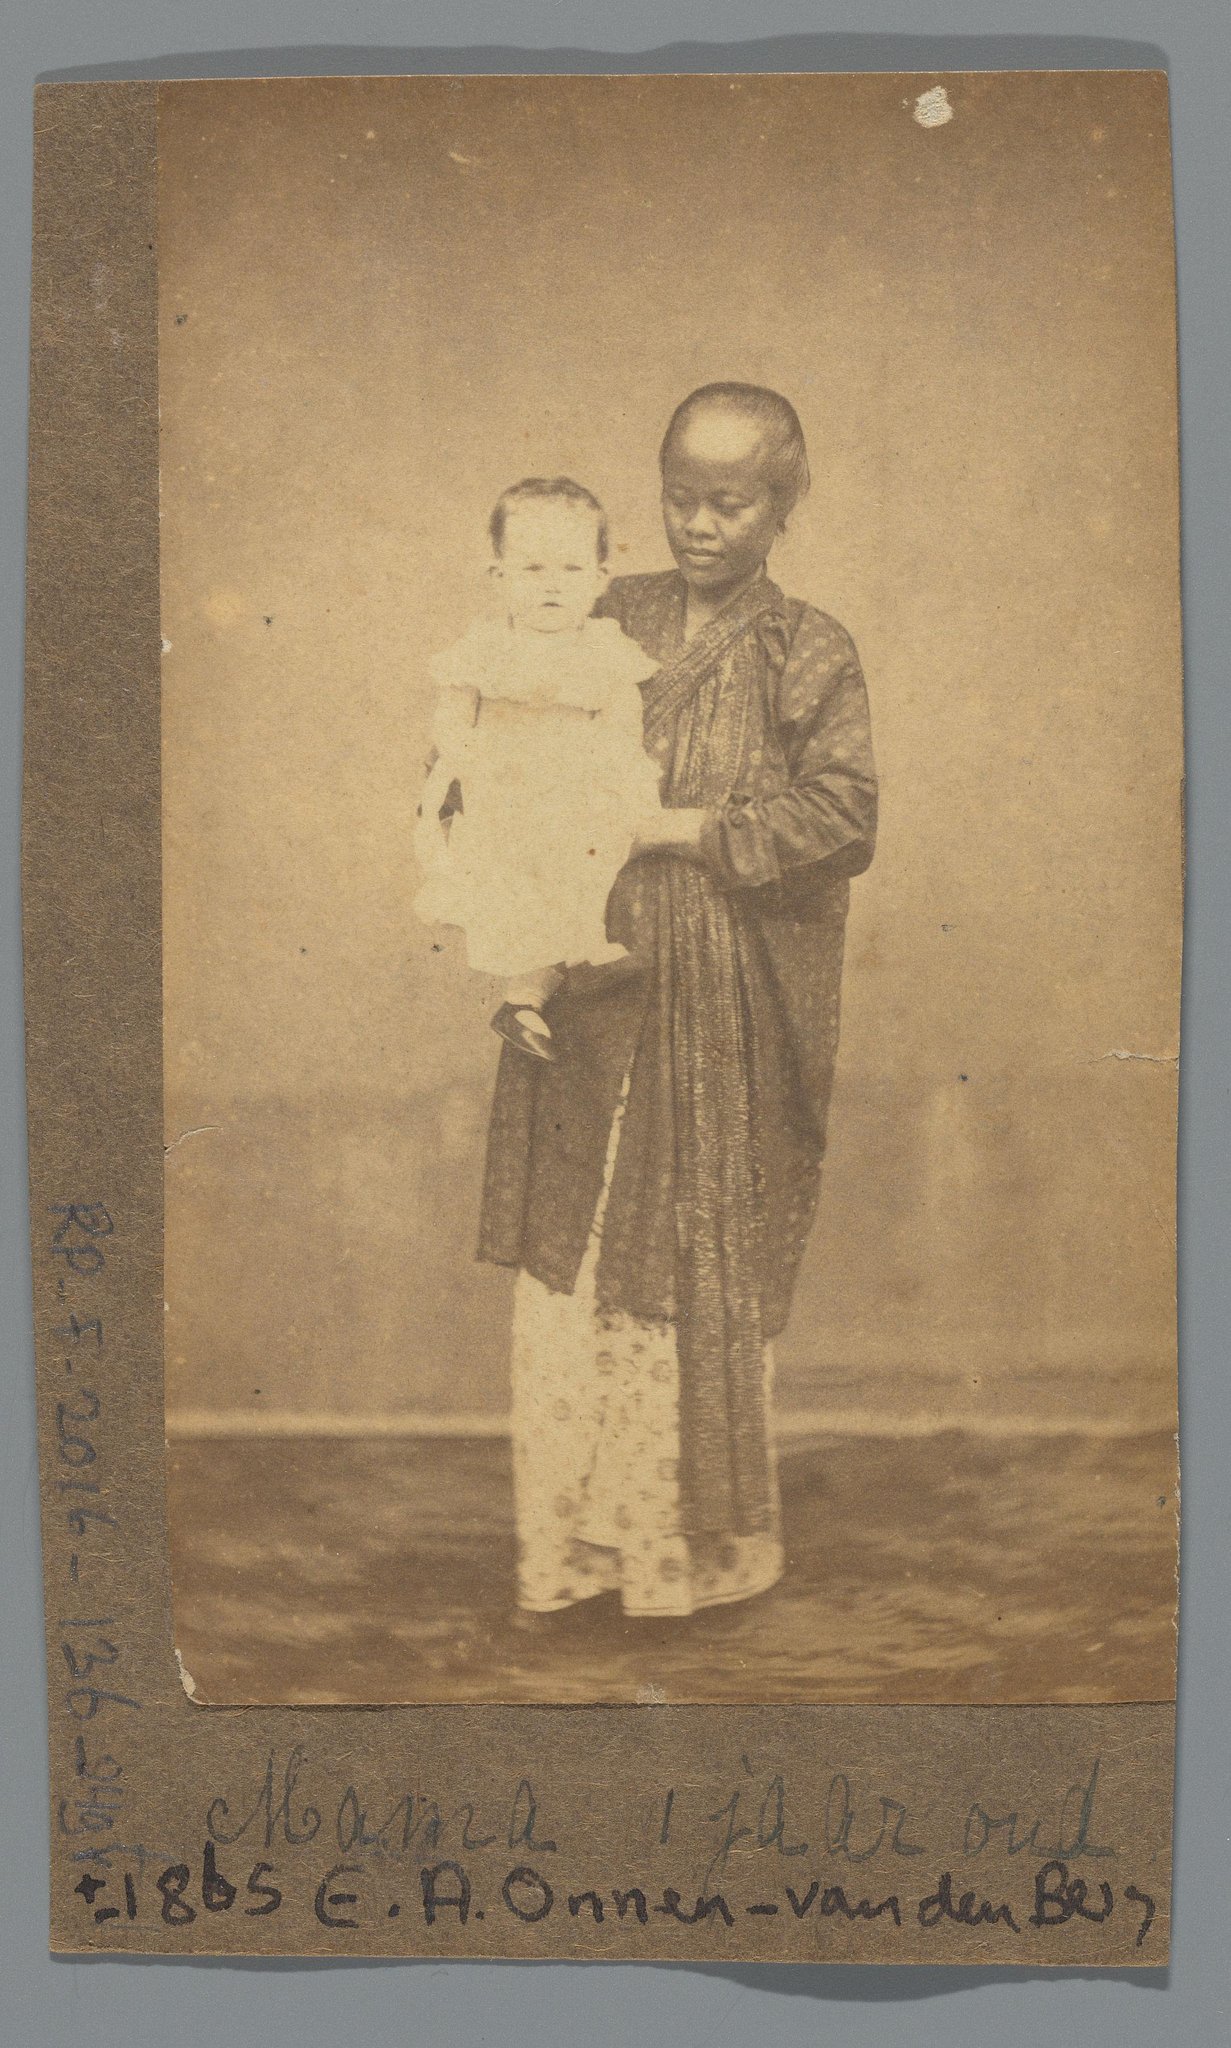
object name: photograph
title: Portret van Emilie A. Onnen-van den Berg als baby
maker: Anonymous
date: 1865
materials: cardboard, photographic support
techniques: albumen print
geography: dutch east indies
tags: batavia, emilie albertine onnen-van den berg, dutch east indies, the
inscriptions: inscription: ‘Mama 1 jaar oud’, inscription: ‘±1865 E.A. Onnen-van den Berg’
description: Portret van Emilie A. Onnen-van den Berg als baby in de armen van een Indonesische vrouw.